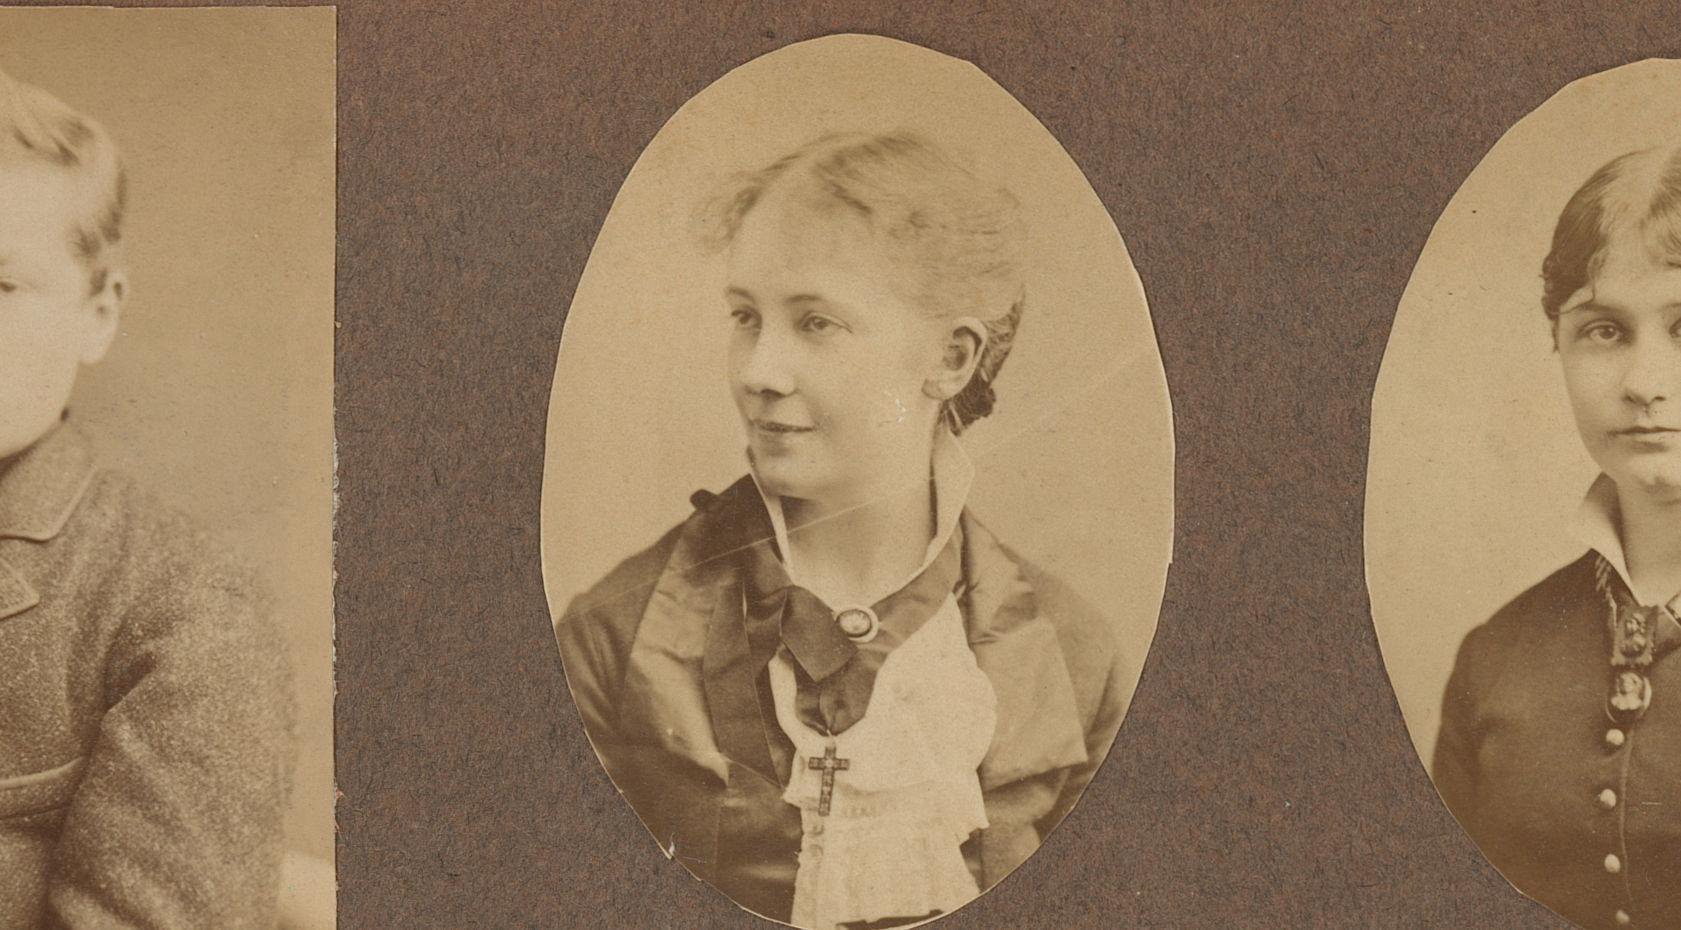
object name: photograph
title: Portret van jonge vrouw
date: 1877-1884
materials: photographic support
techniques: photography, snipping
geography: netherlands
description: Foto op bruin albumblad 16 van familiealbum van Alphons Diepenbrock.